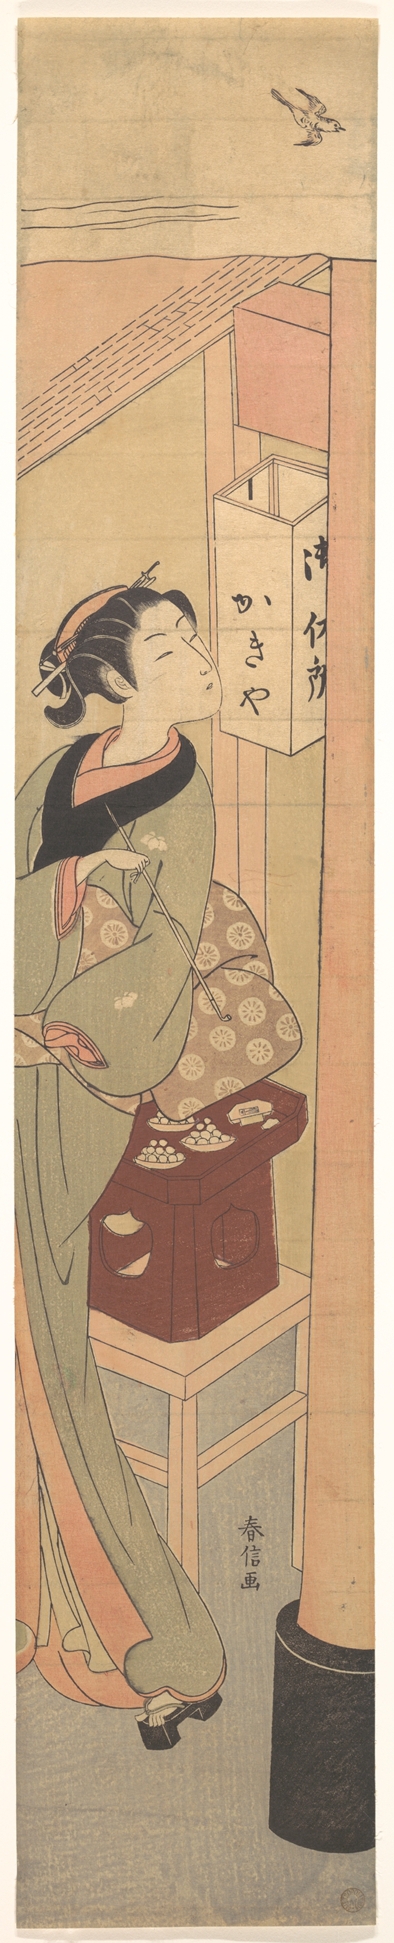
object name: print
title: Osen of the Kagiya Teahouse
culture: japanese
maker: suzuki harunobu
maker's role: artist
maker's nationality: japanese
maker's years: 1725-1770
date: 1769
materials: ink, paper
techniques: hashira, woodblock print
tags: women,tea houses,pipes